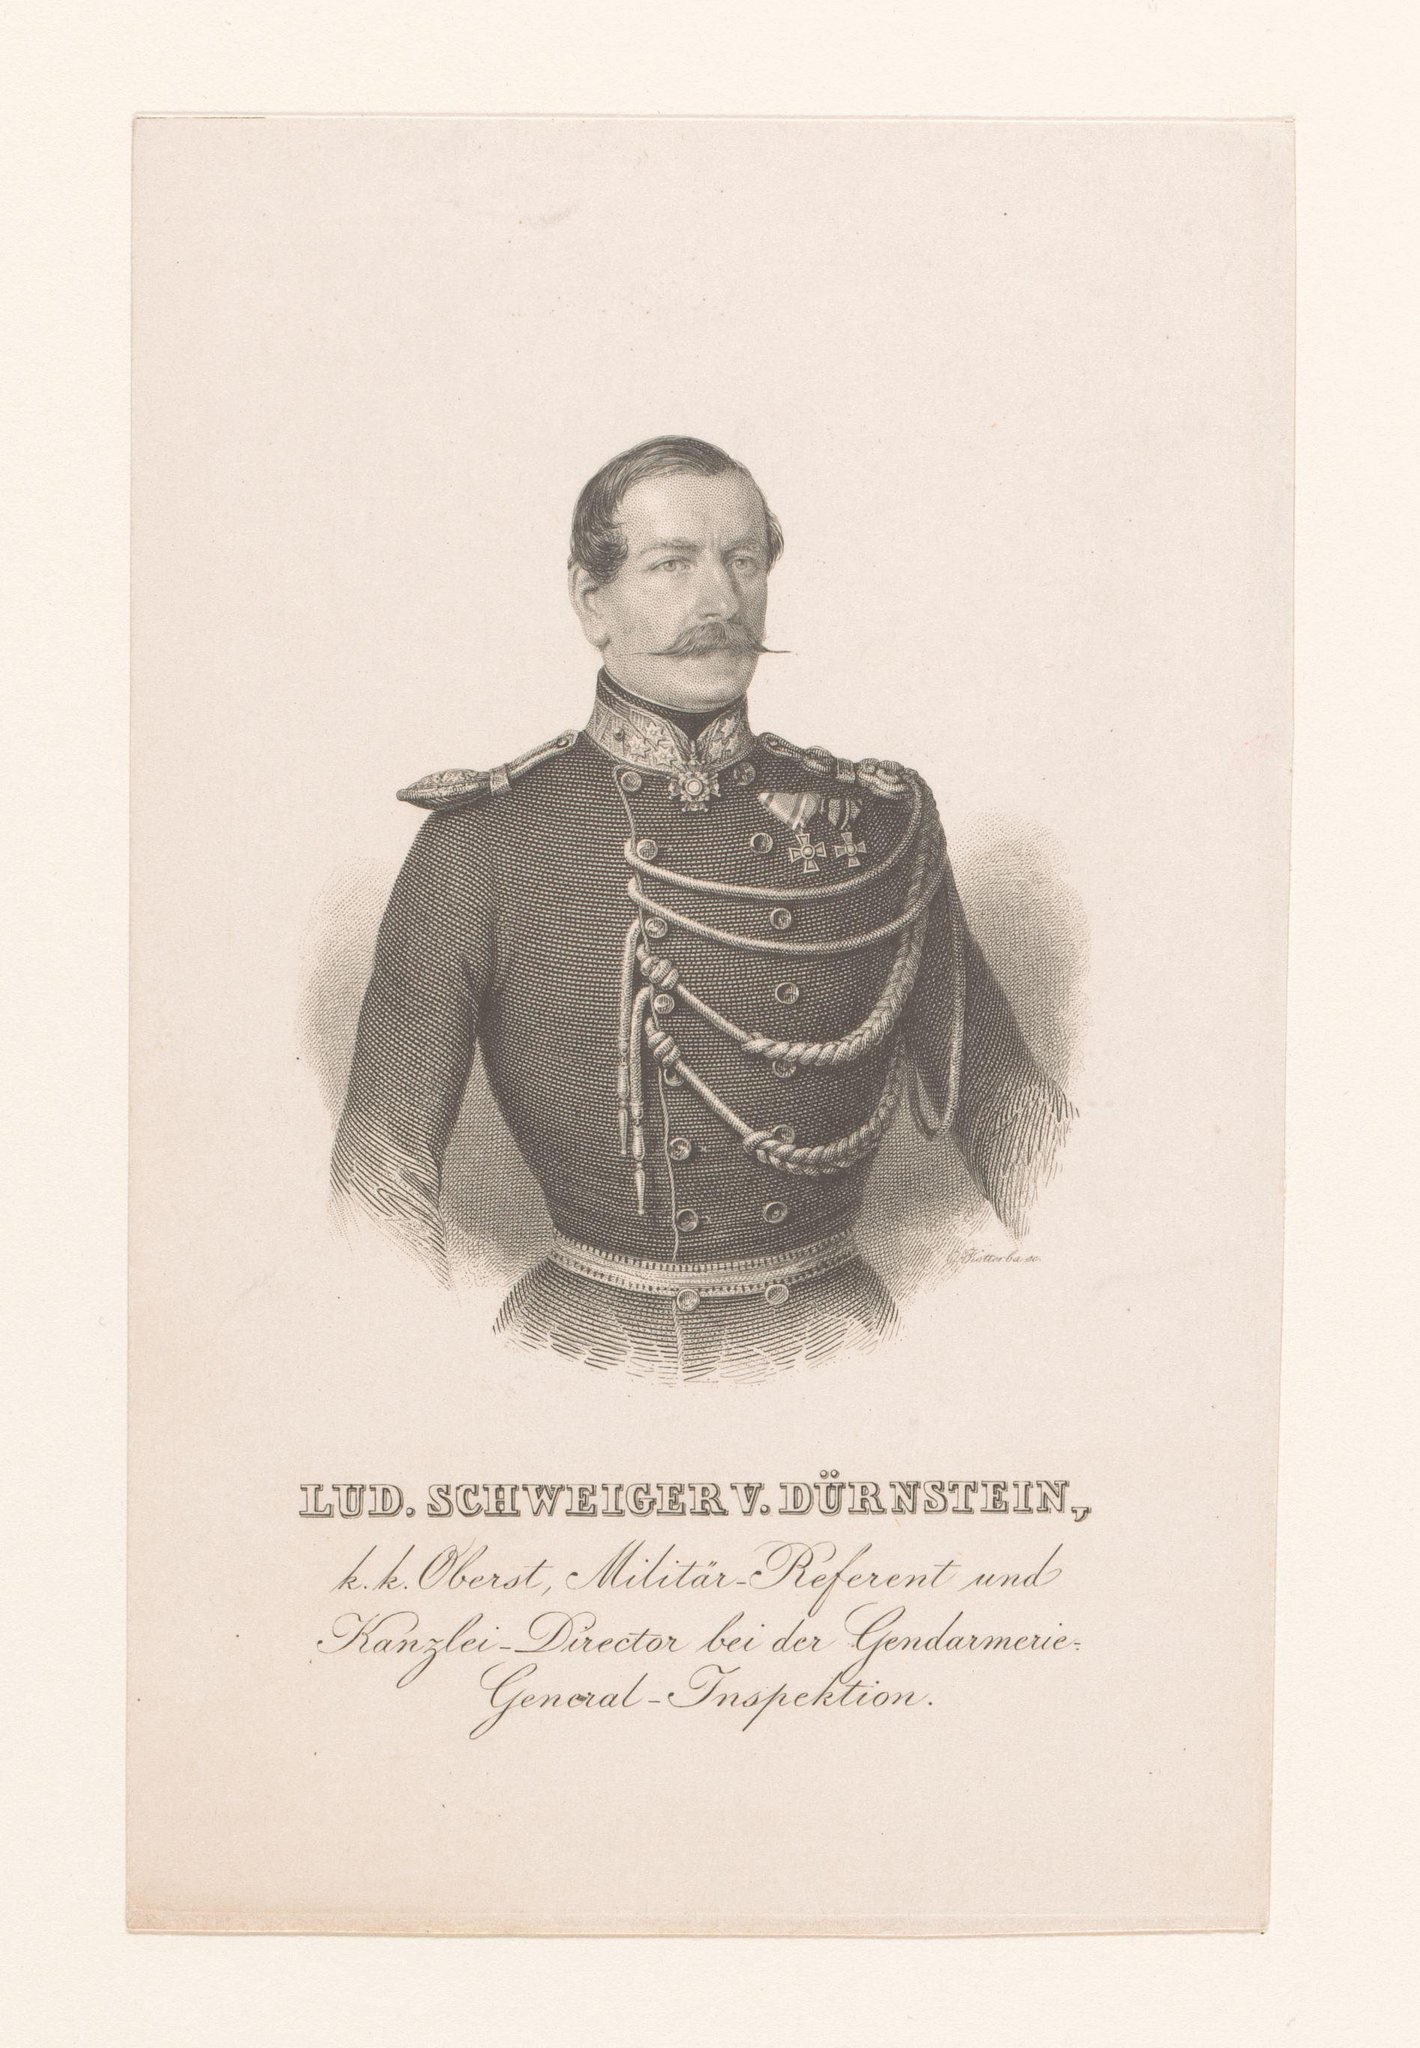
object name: print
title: Portret van Ludwig Schweiger von Dürnstein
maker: carl kotterba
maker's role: print maker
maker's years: 1800-1859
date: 1857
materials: paper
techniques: engraving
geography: vienna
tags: historical persons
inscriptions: collector's mark: Lugt 2228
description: Prent uit: Ehrenstein, Friedrich. Oesterreichischer Gendarmerie-Almanach für 1857. Wenen: Kaiserlich-Königlich Hof und Staatsdruckerei, 1857, p. 9.